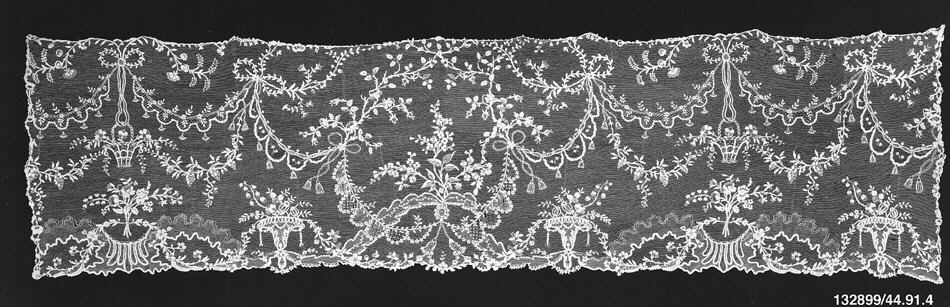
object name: flounce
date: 1751-1775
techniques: lace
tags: flowers